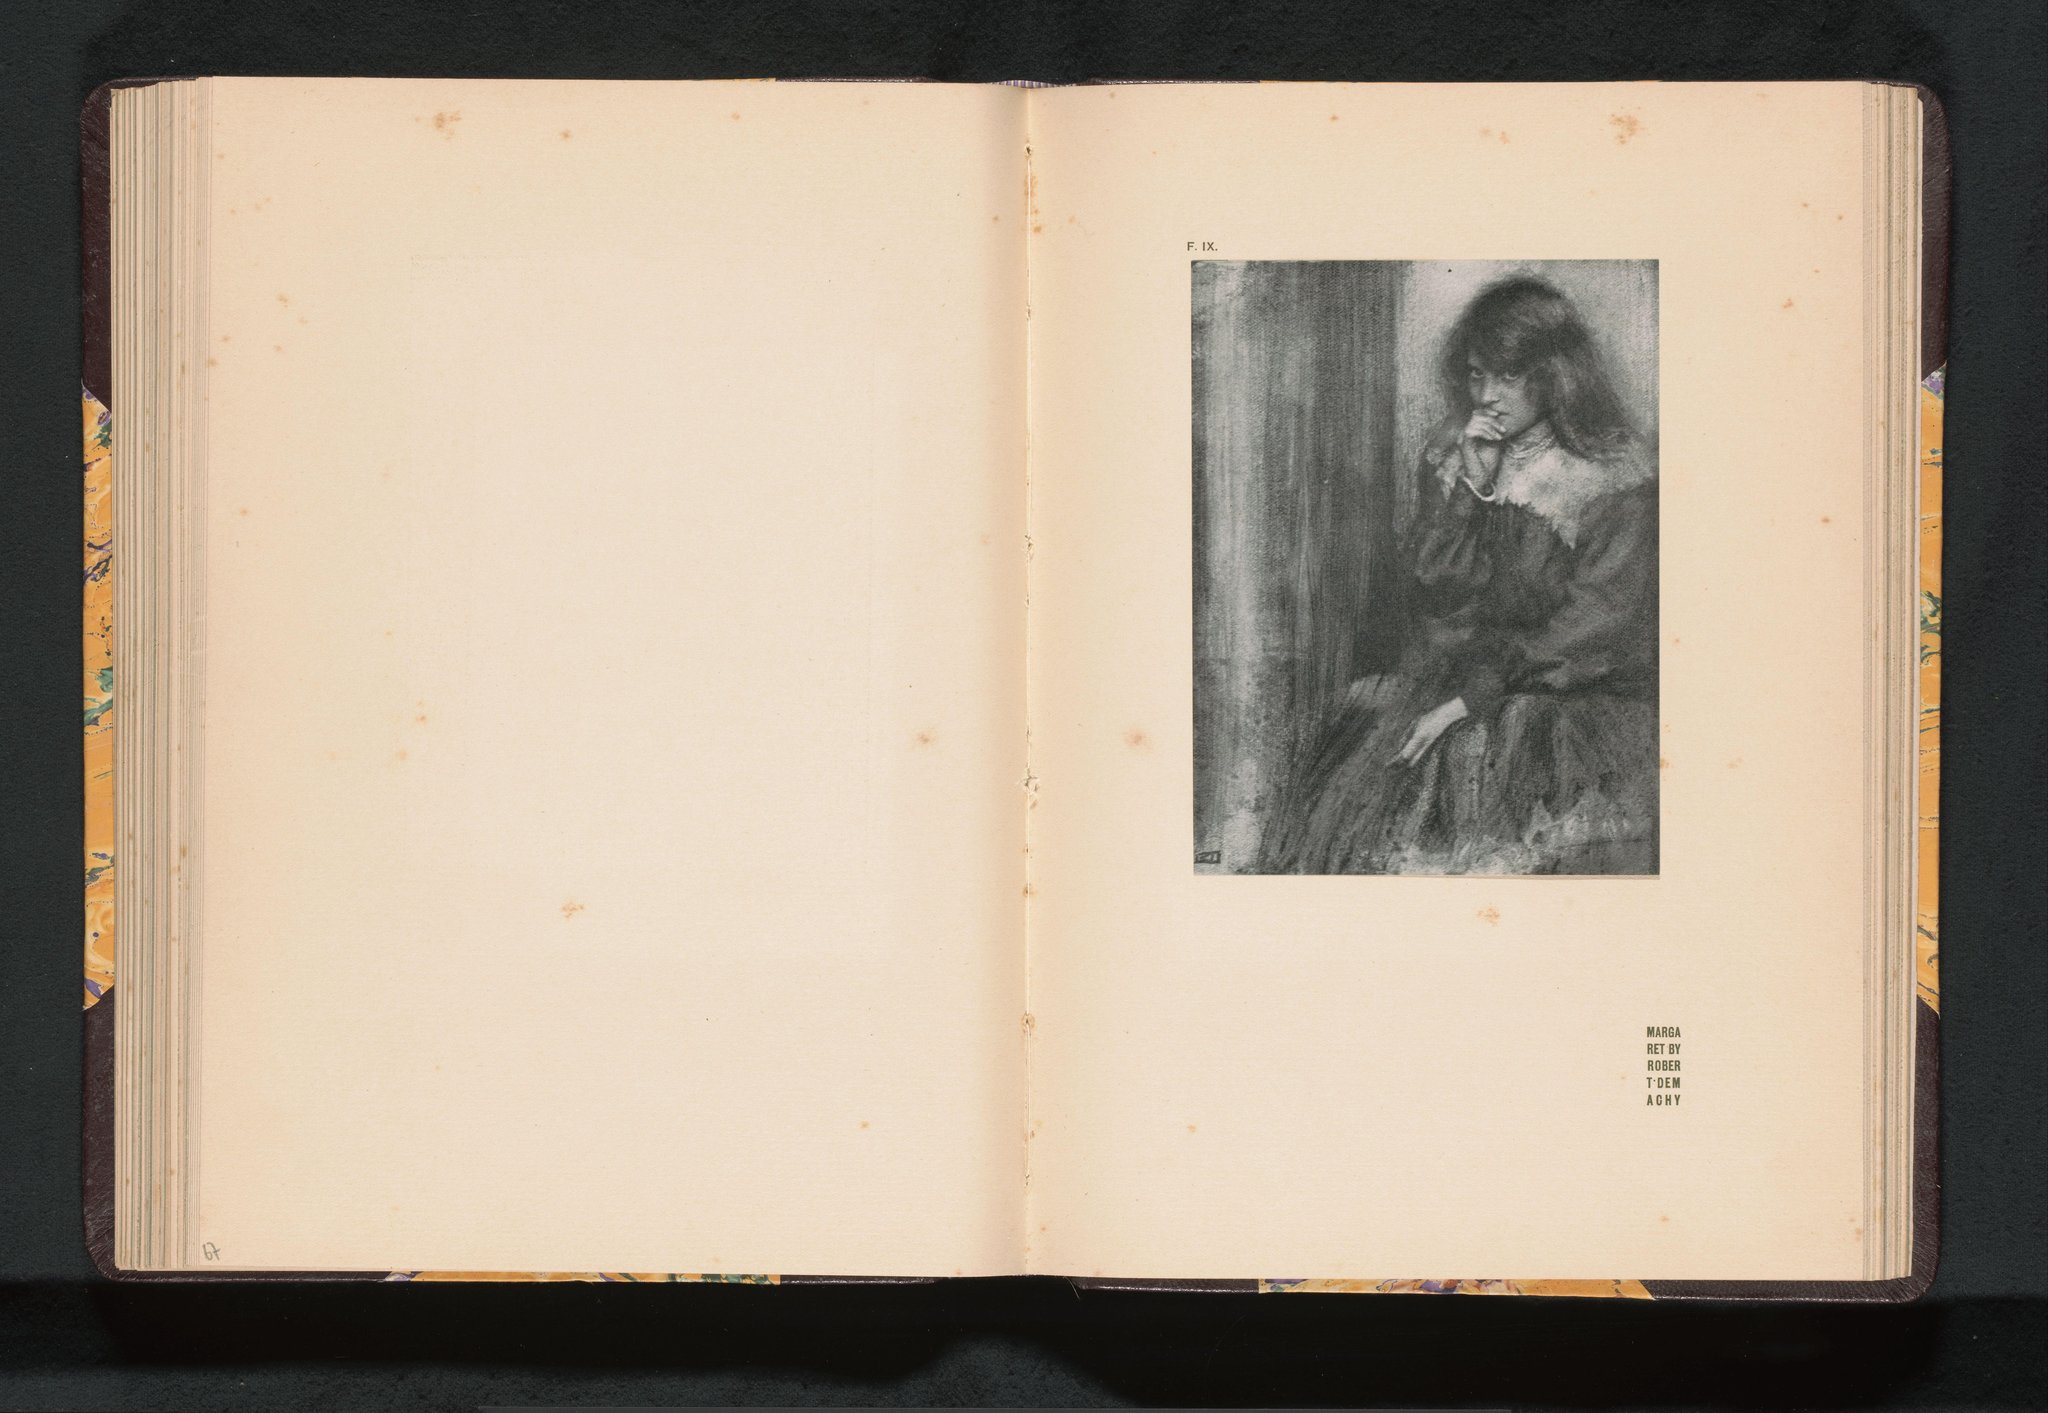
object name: page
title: Portret van een onbekend meisje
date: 1900-1905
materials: paper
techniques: two-color autotype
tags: adolescent, young woman, maiden, historical persons - bb - woman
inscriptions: inscription: ‘F. IX.’, inscription: ‘Margaret by Robert Demachy’